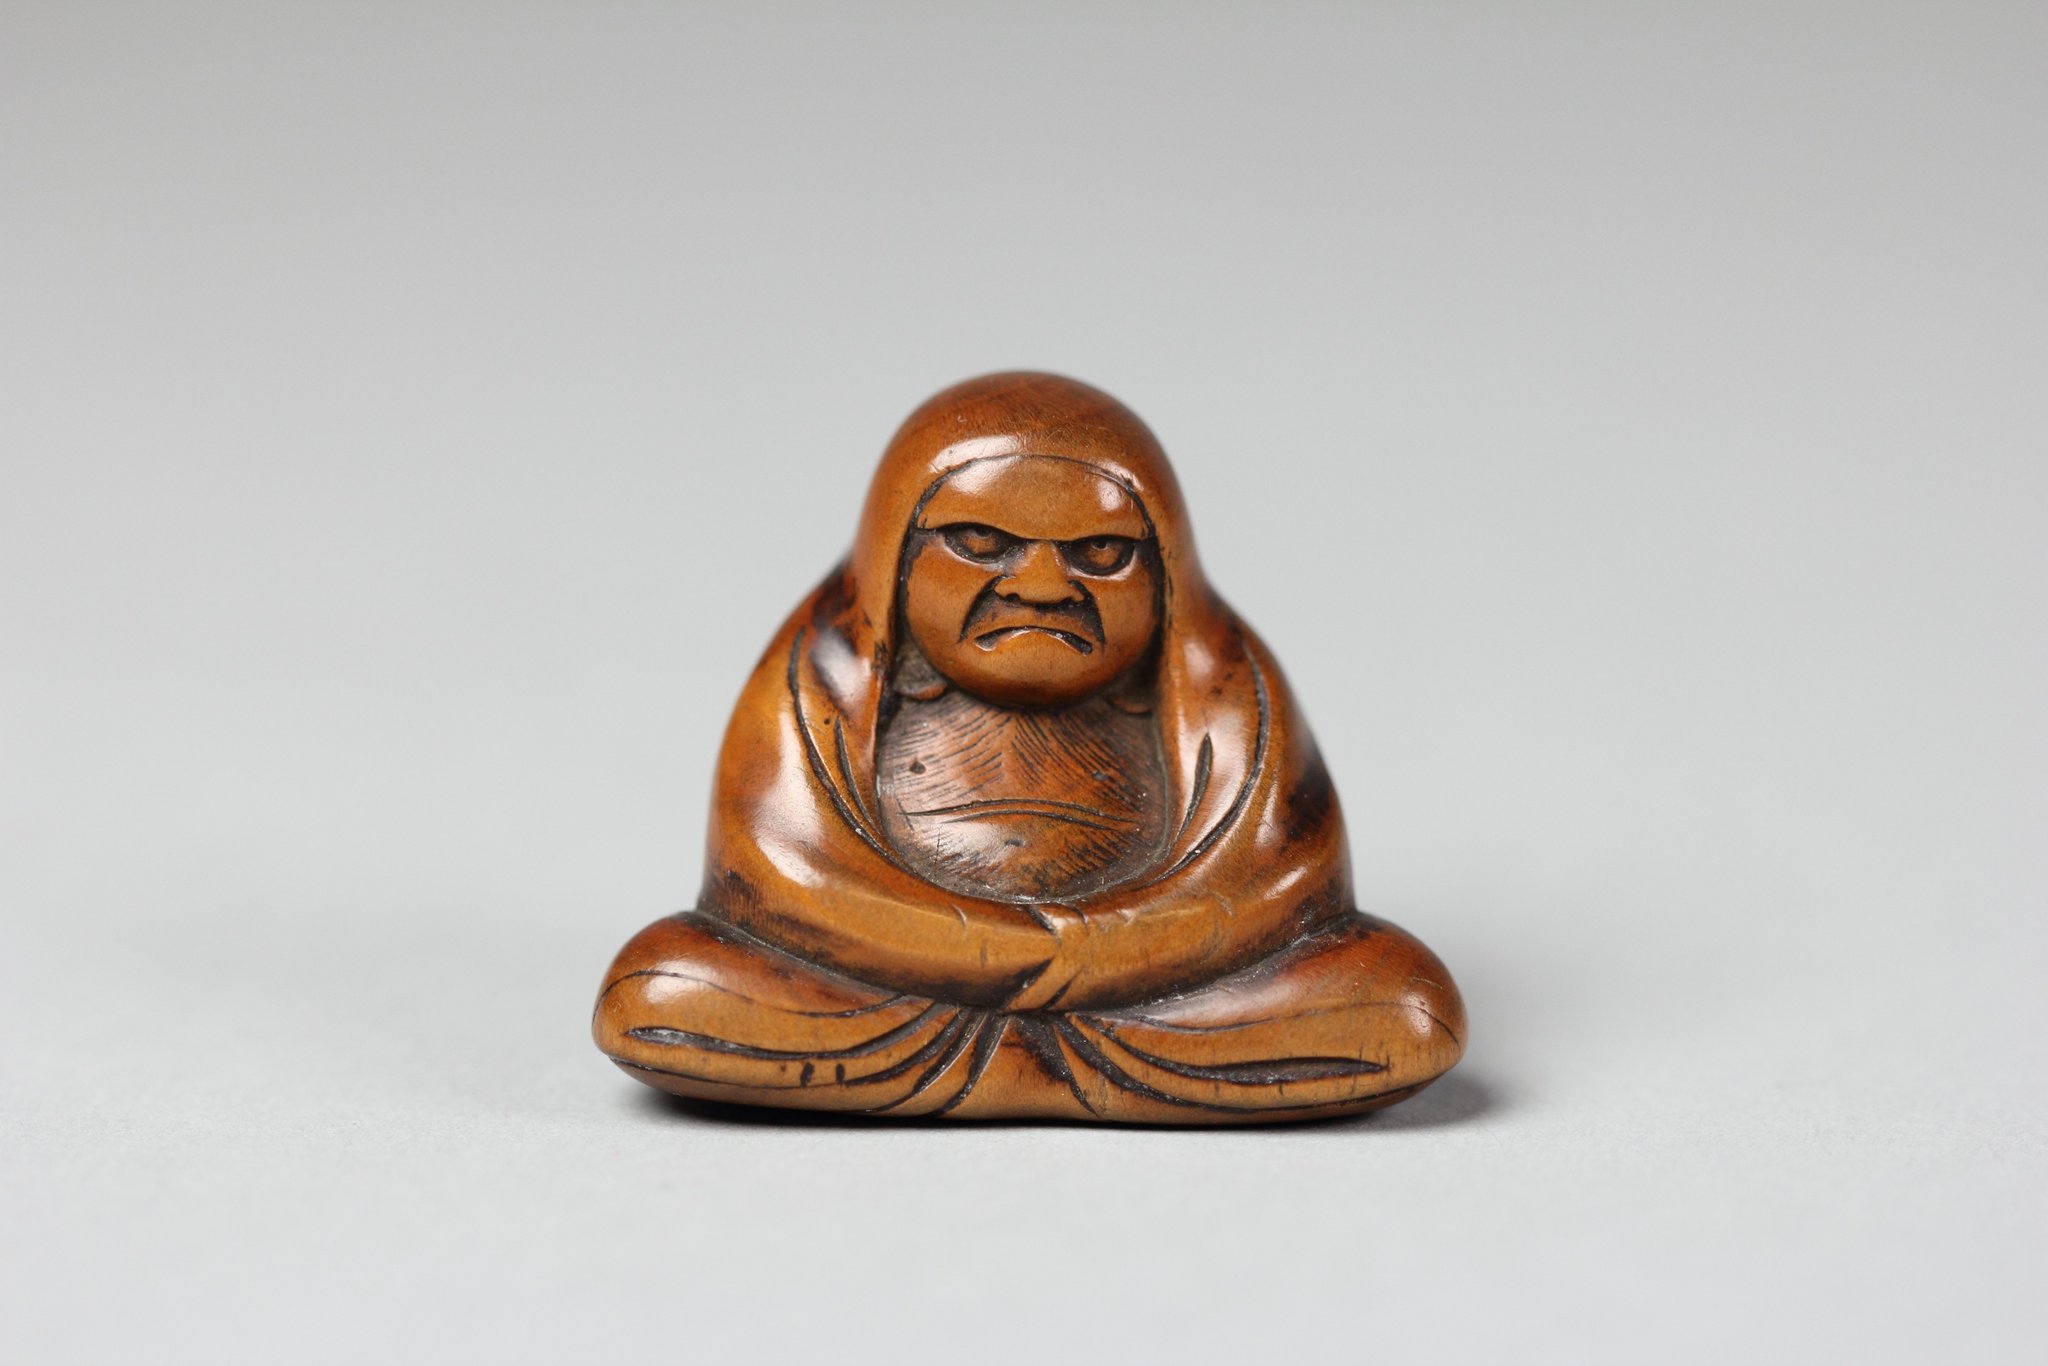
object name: netsuke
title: Netsuke of Seated Figure; Daruma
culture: japanese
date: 1801-1900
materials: wood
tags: men